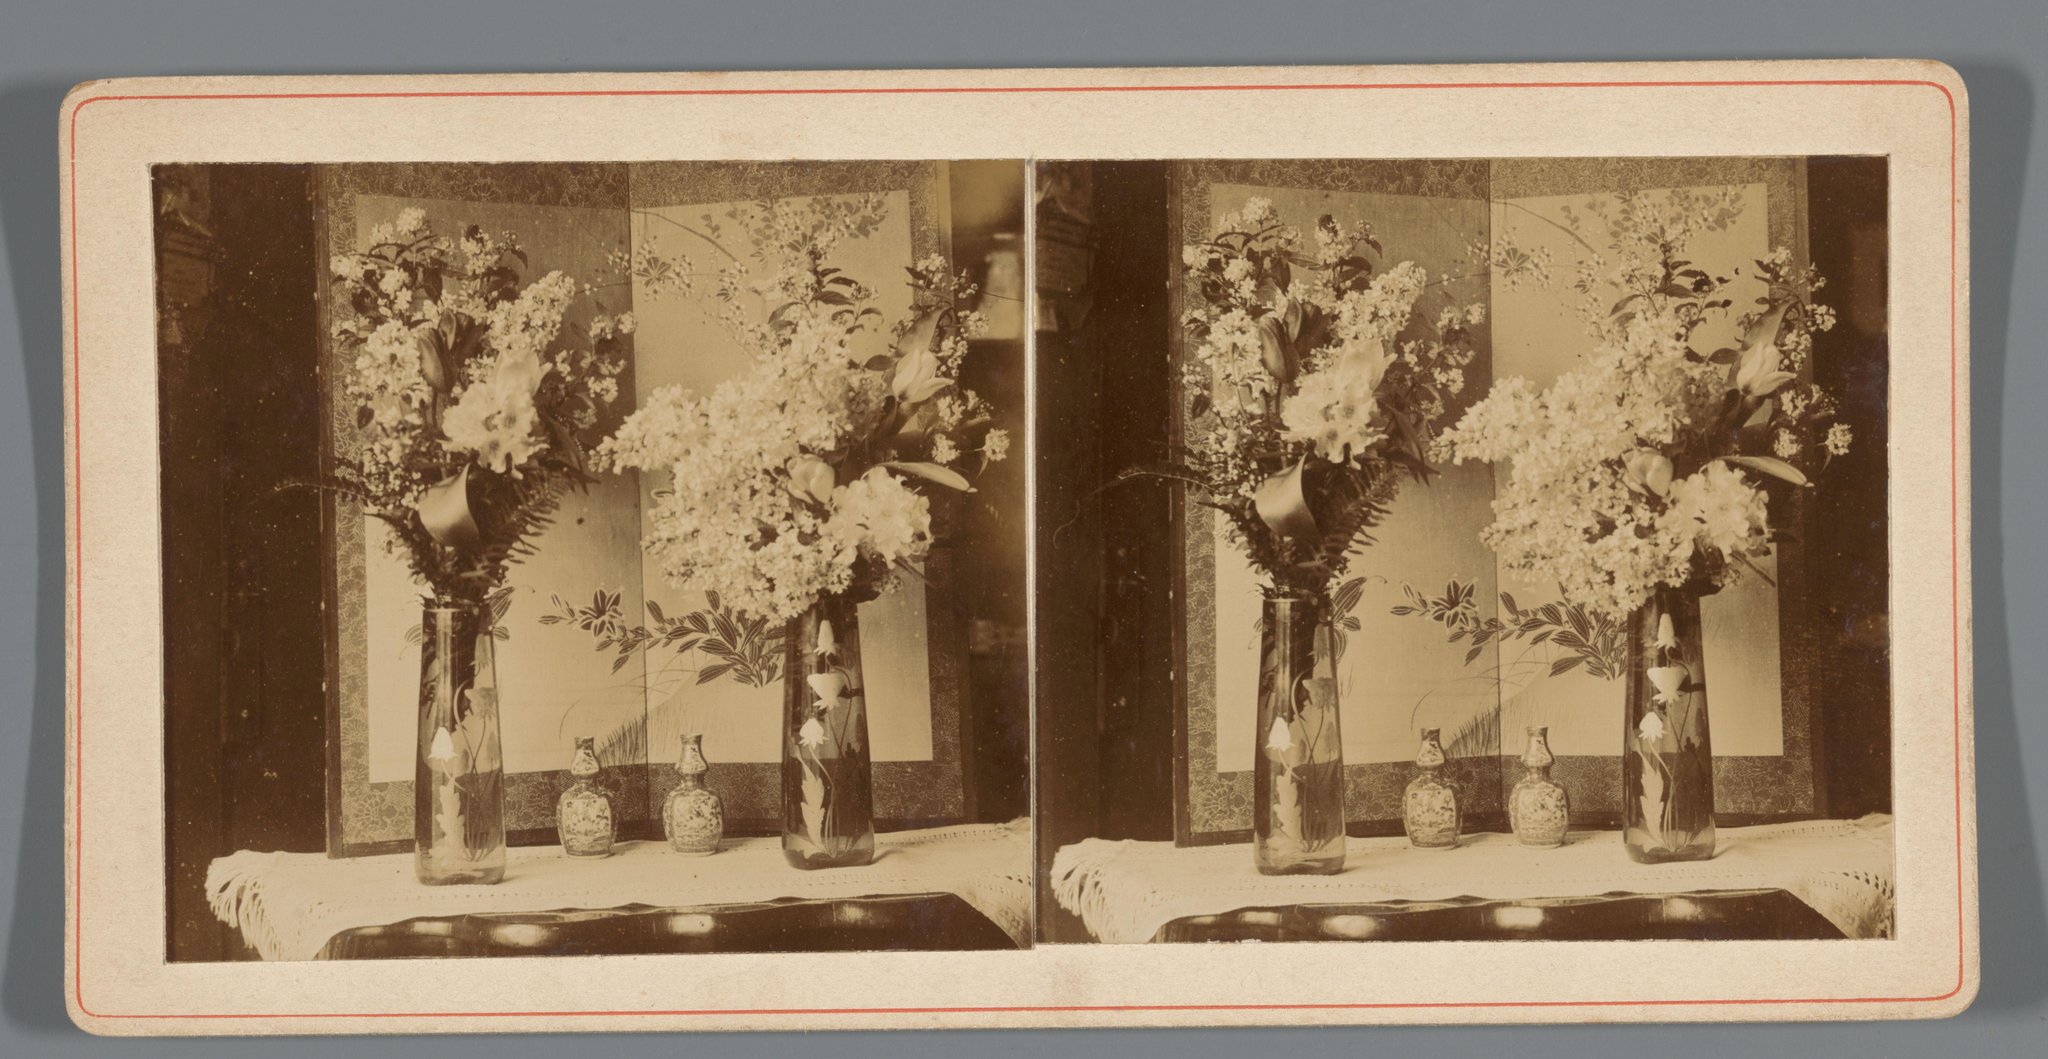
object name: stereograph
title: Twee vazen met bloemen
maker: Anonymous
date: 1900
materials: cardboard, photographic support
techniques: gelatin silver print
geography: netherlands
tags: flowers in a vase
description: Twee vazen met bloemen. Onderdeel van een groep van 5 foto's en 19 stereofoto's gemaakt door een onbekende amateurfotograaf rond 1900 in Amsterdam, de Ardennen en Denemarken.